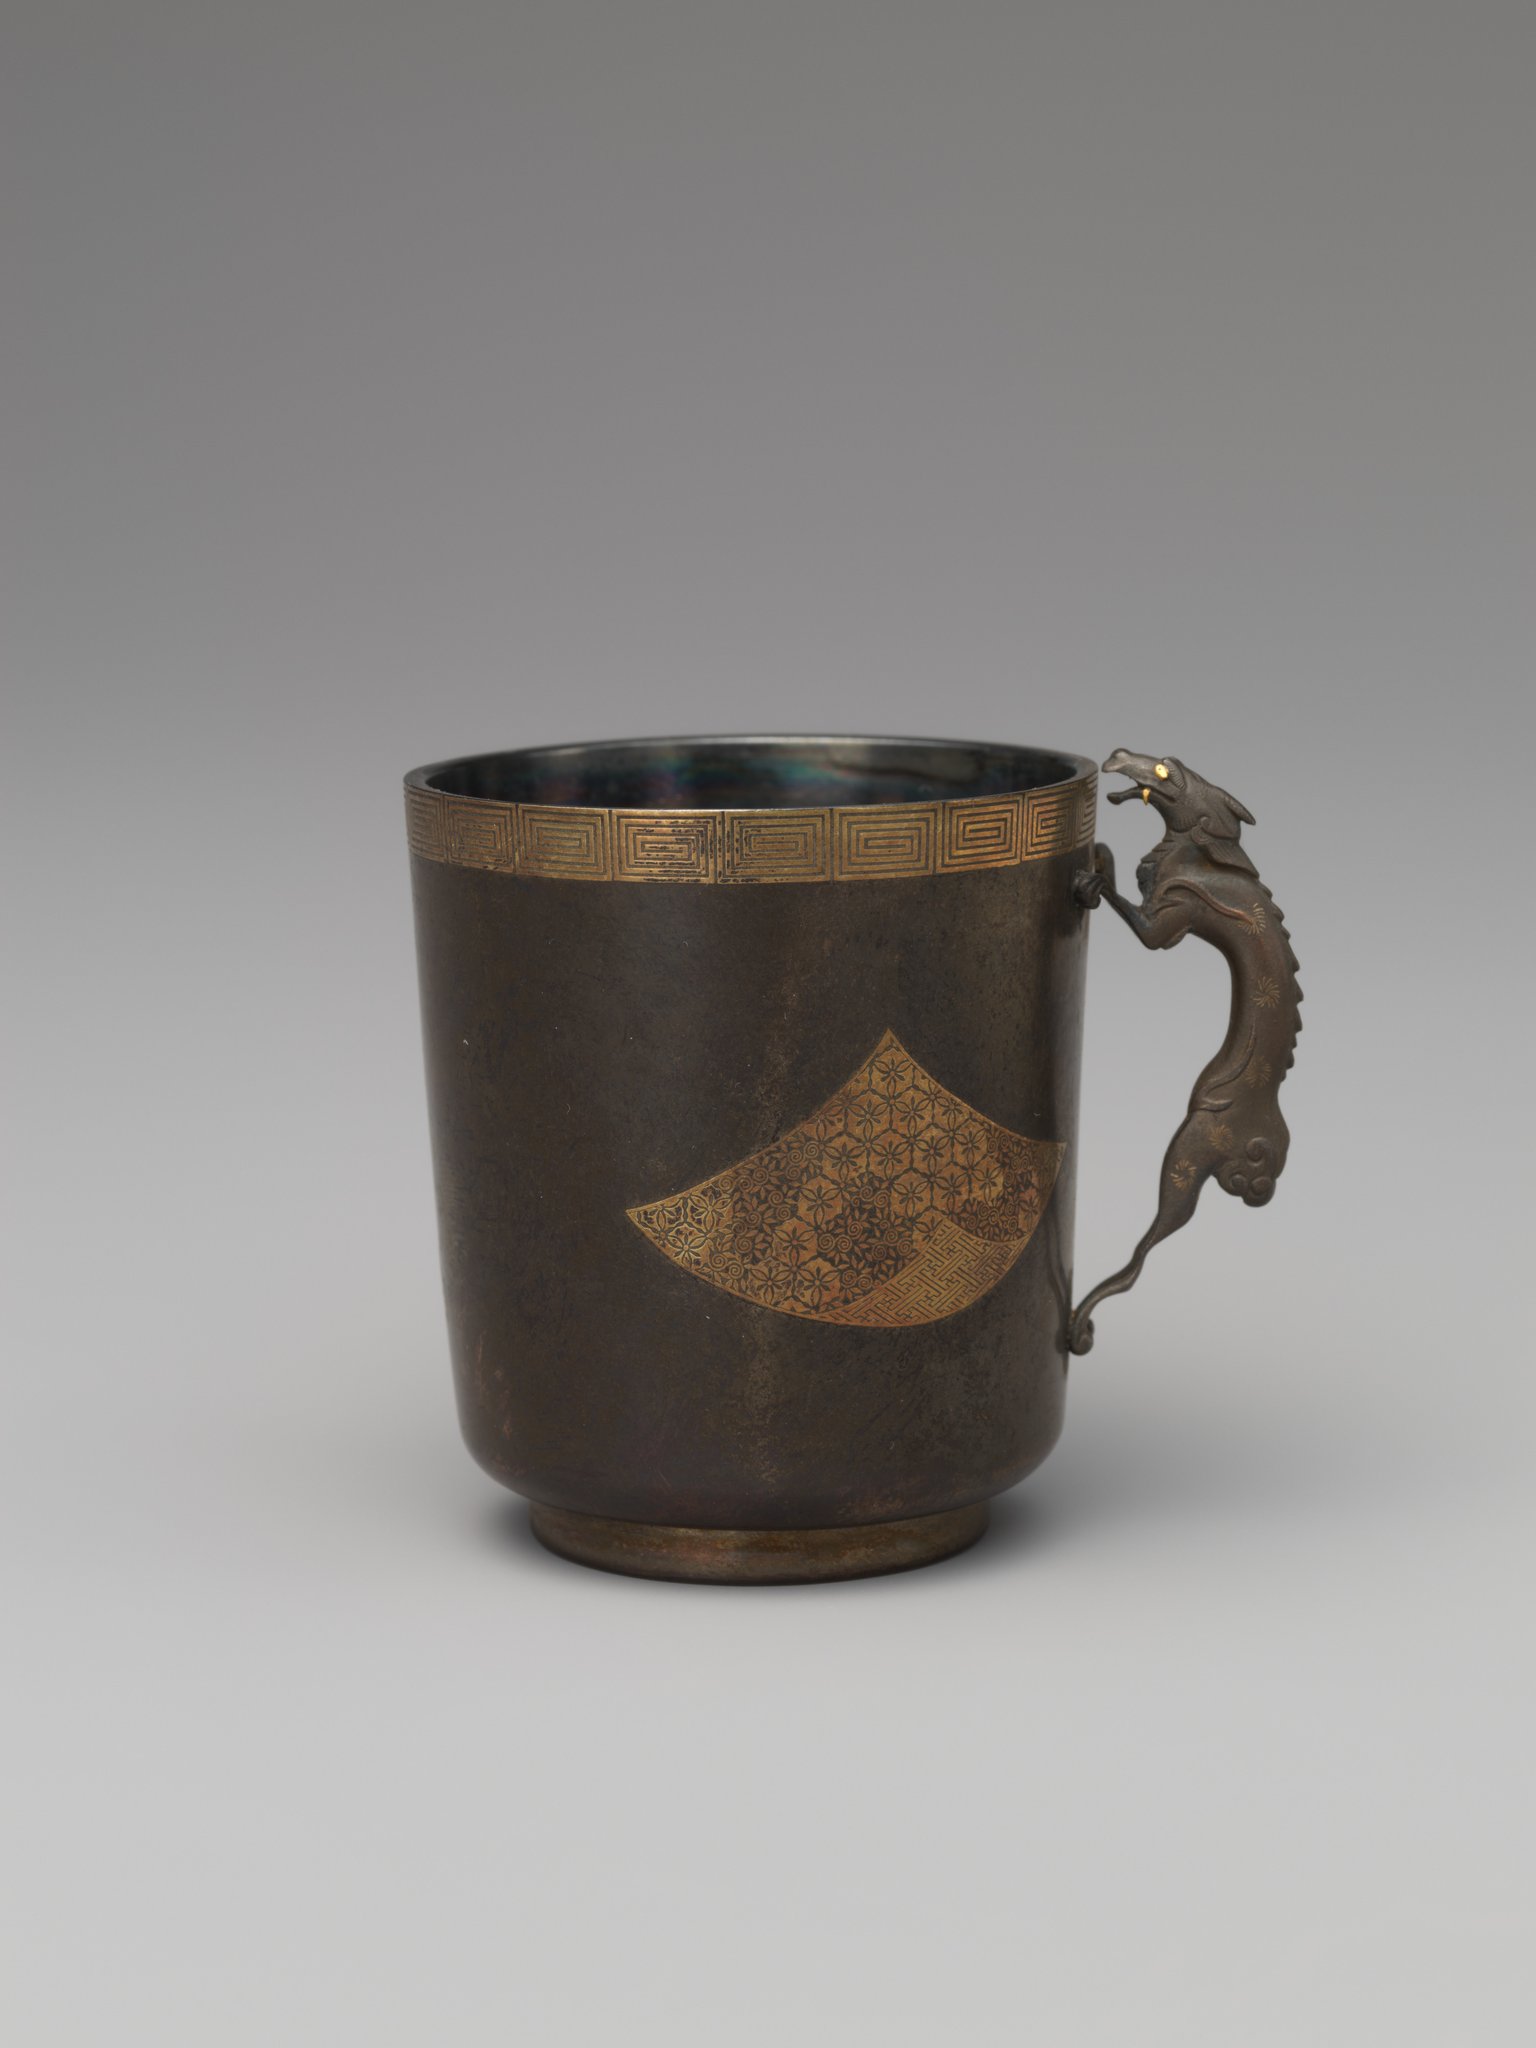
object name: cup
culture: japanese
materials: silver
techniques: gilding